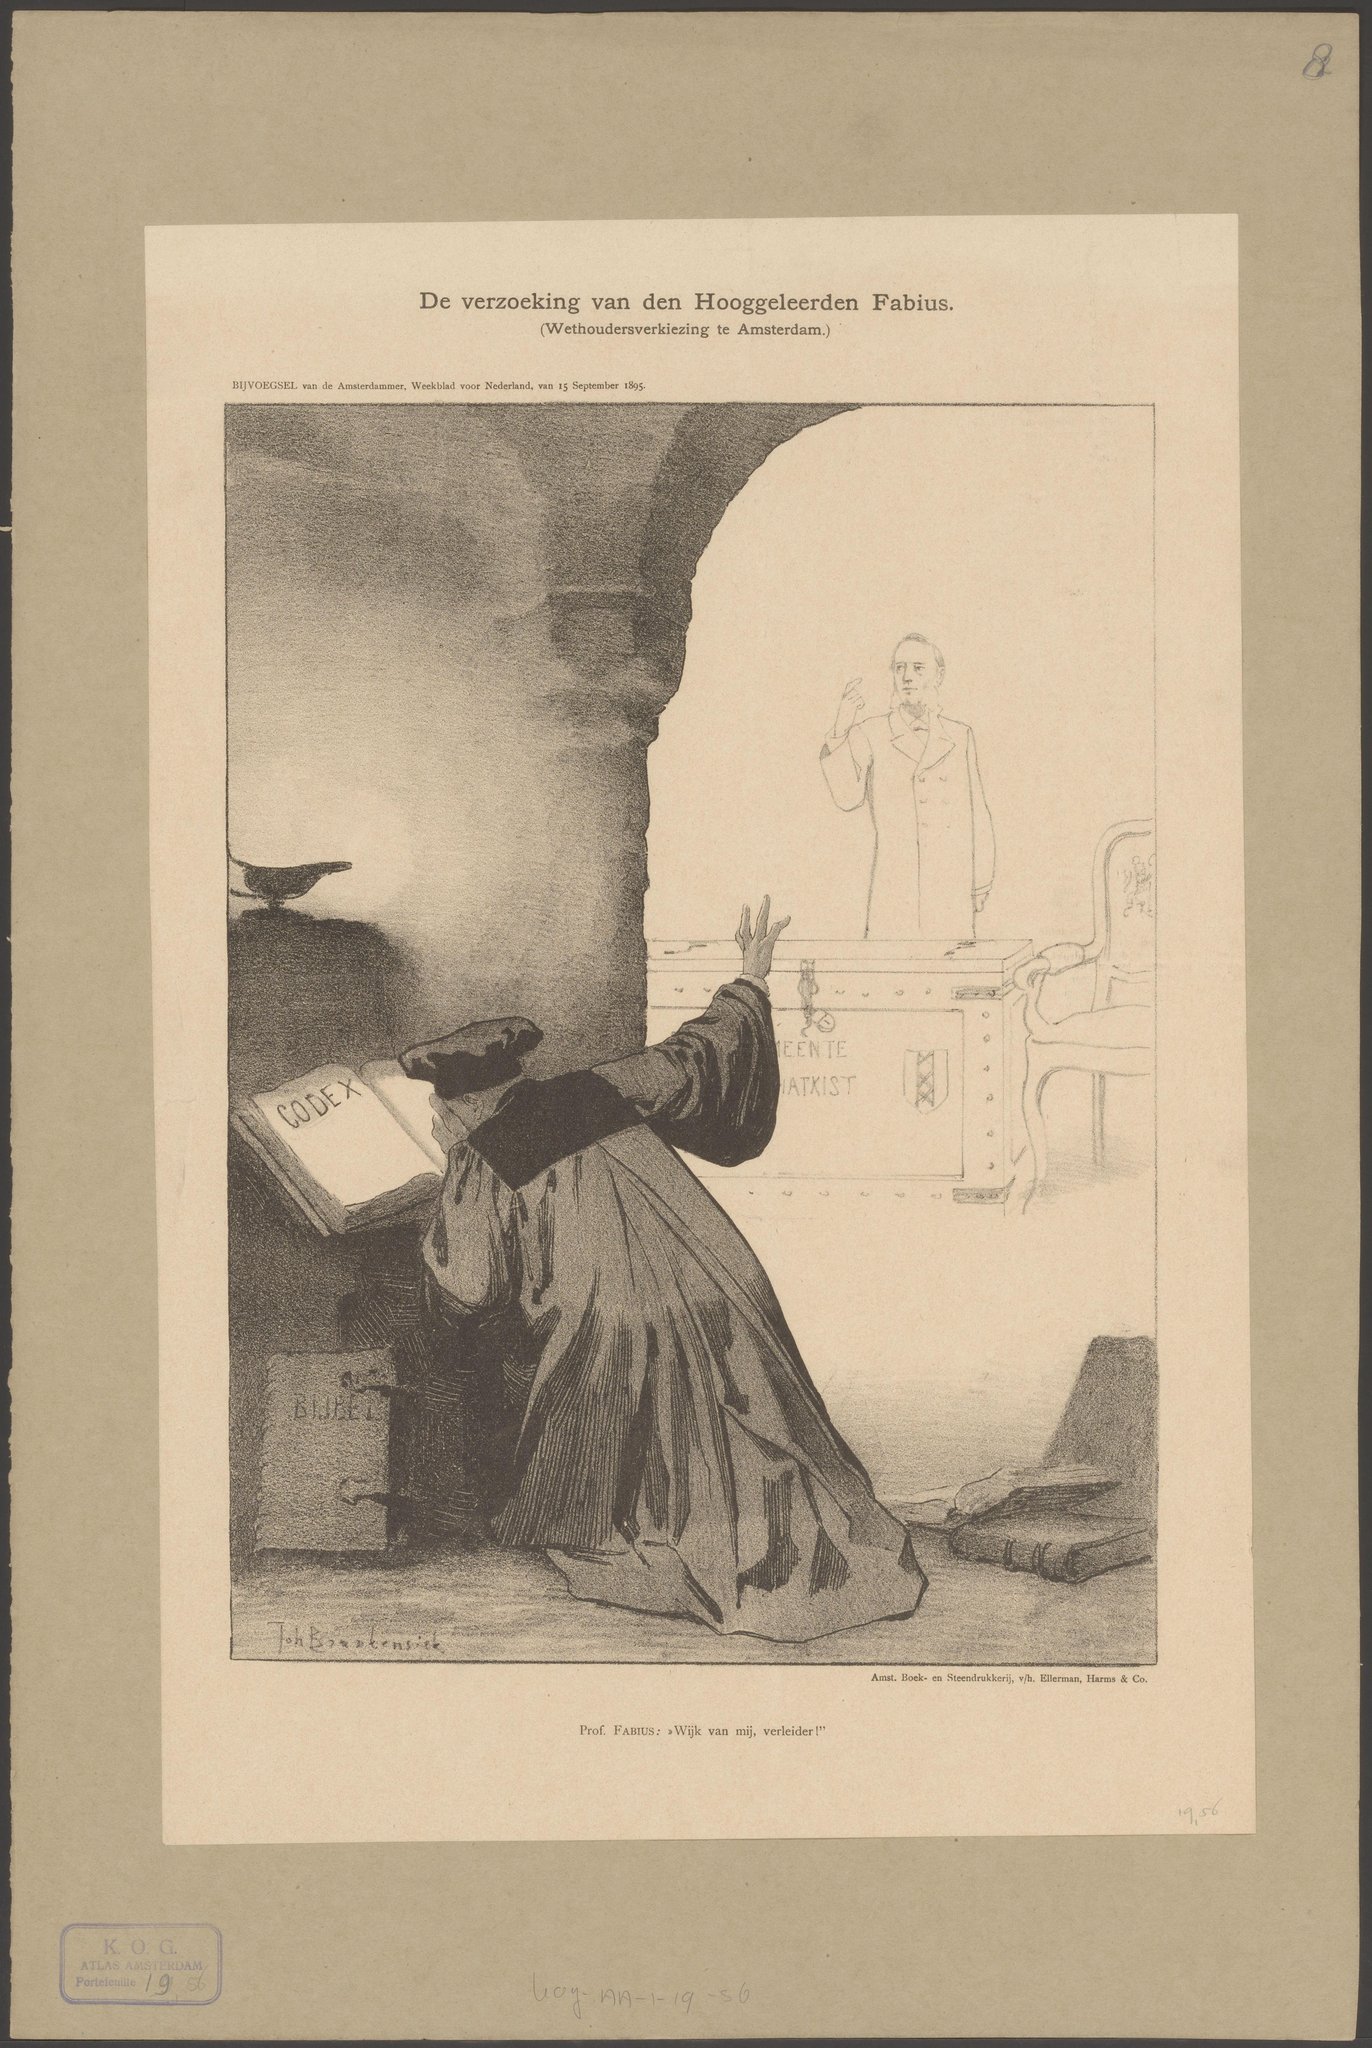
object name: cartoon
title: De verzoeking van den Hooggeleerden Fabius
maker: johan braakensiek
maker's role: draughtsman, print maker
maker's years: 1858-1940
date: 1895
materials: paper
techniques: letterpress printing, lithograph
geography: amsterdam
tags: politician, city council, political caricatures and satires, amsterdam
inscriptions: collector's mark: ‘19,56’ Lugt 1641b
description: Onderwerpsrubriek binnen de Atlas Amsterdam: Herinneringen aan regeringsleden en hunne huisgezinnen [na 1800]. De hoogleraar Paul Fabius als de heilige Antonius die in verzoeking wordt gebracht door de Amsterdamse burgemeester Vening Meinesz, staande bij de schatkist van de Gemeente Amsterdam.